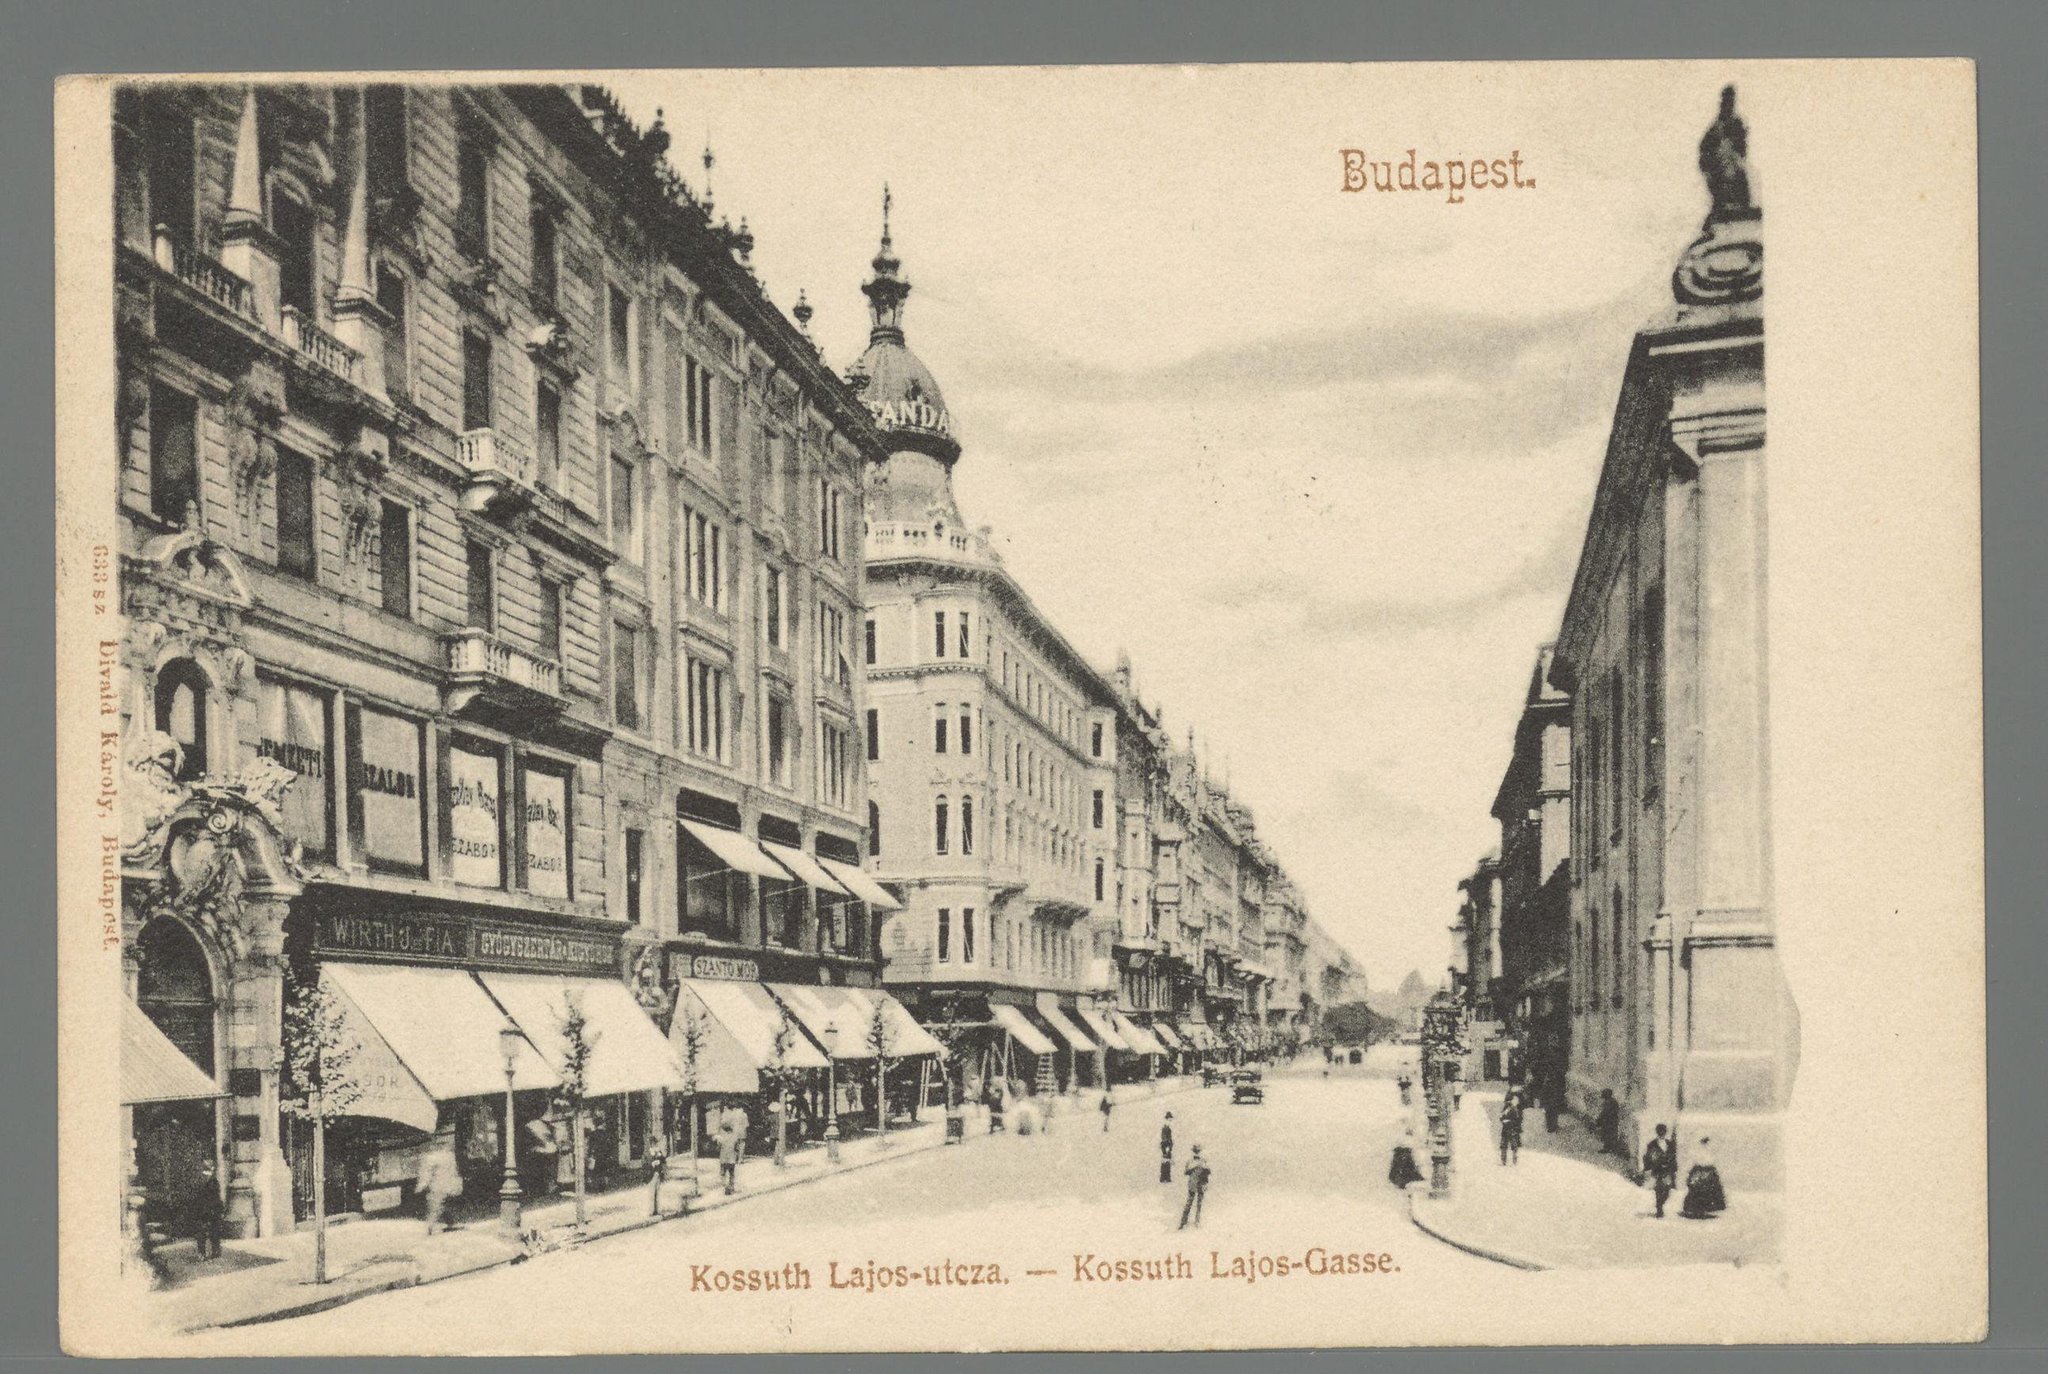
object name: photomechanical print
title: Budapest. Kossuth Lajos-utcza / Kossuth Lajos-Gasse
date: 1890-1903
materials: cardboard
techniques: photograph, writing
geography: budapest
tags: shop, store, street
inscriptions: postage stamp